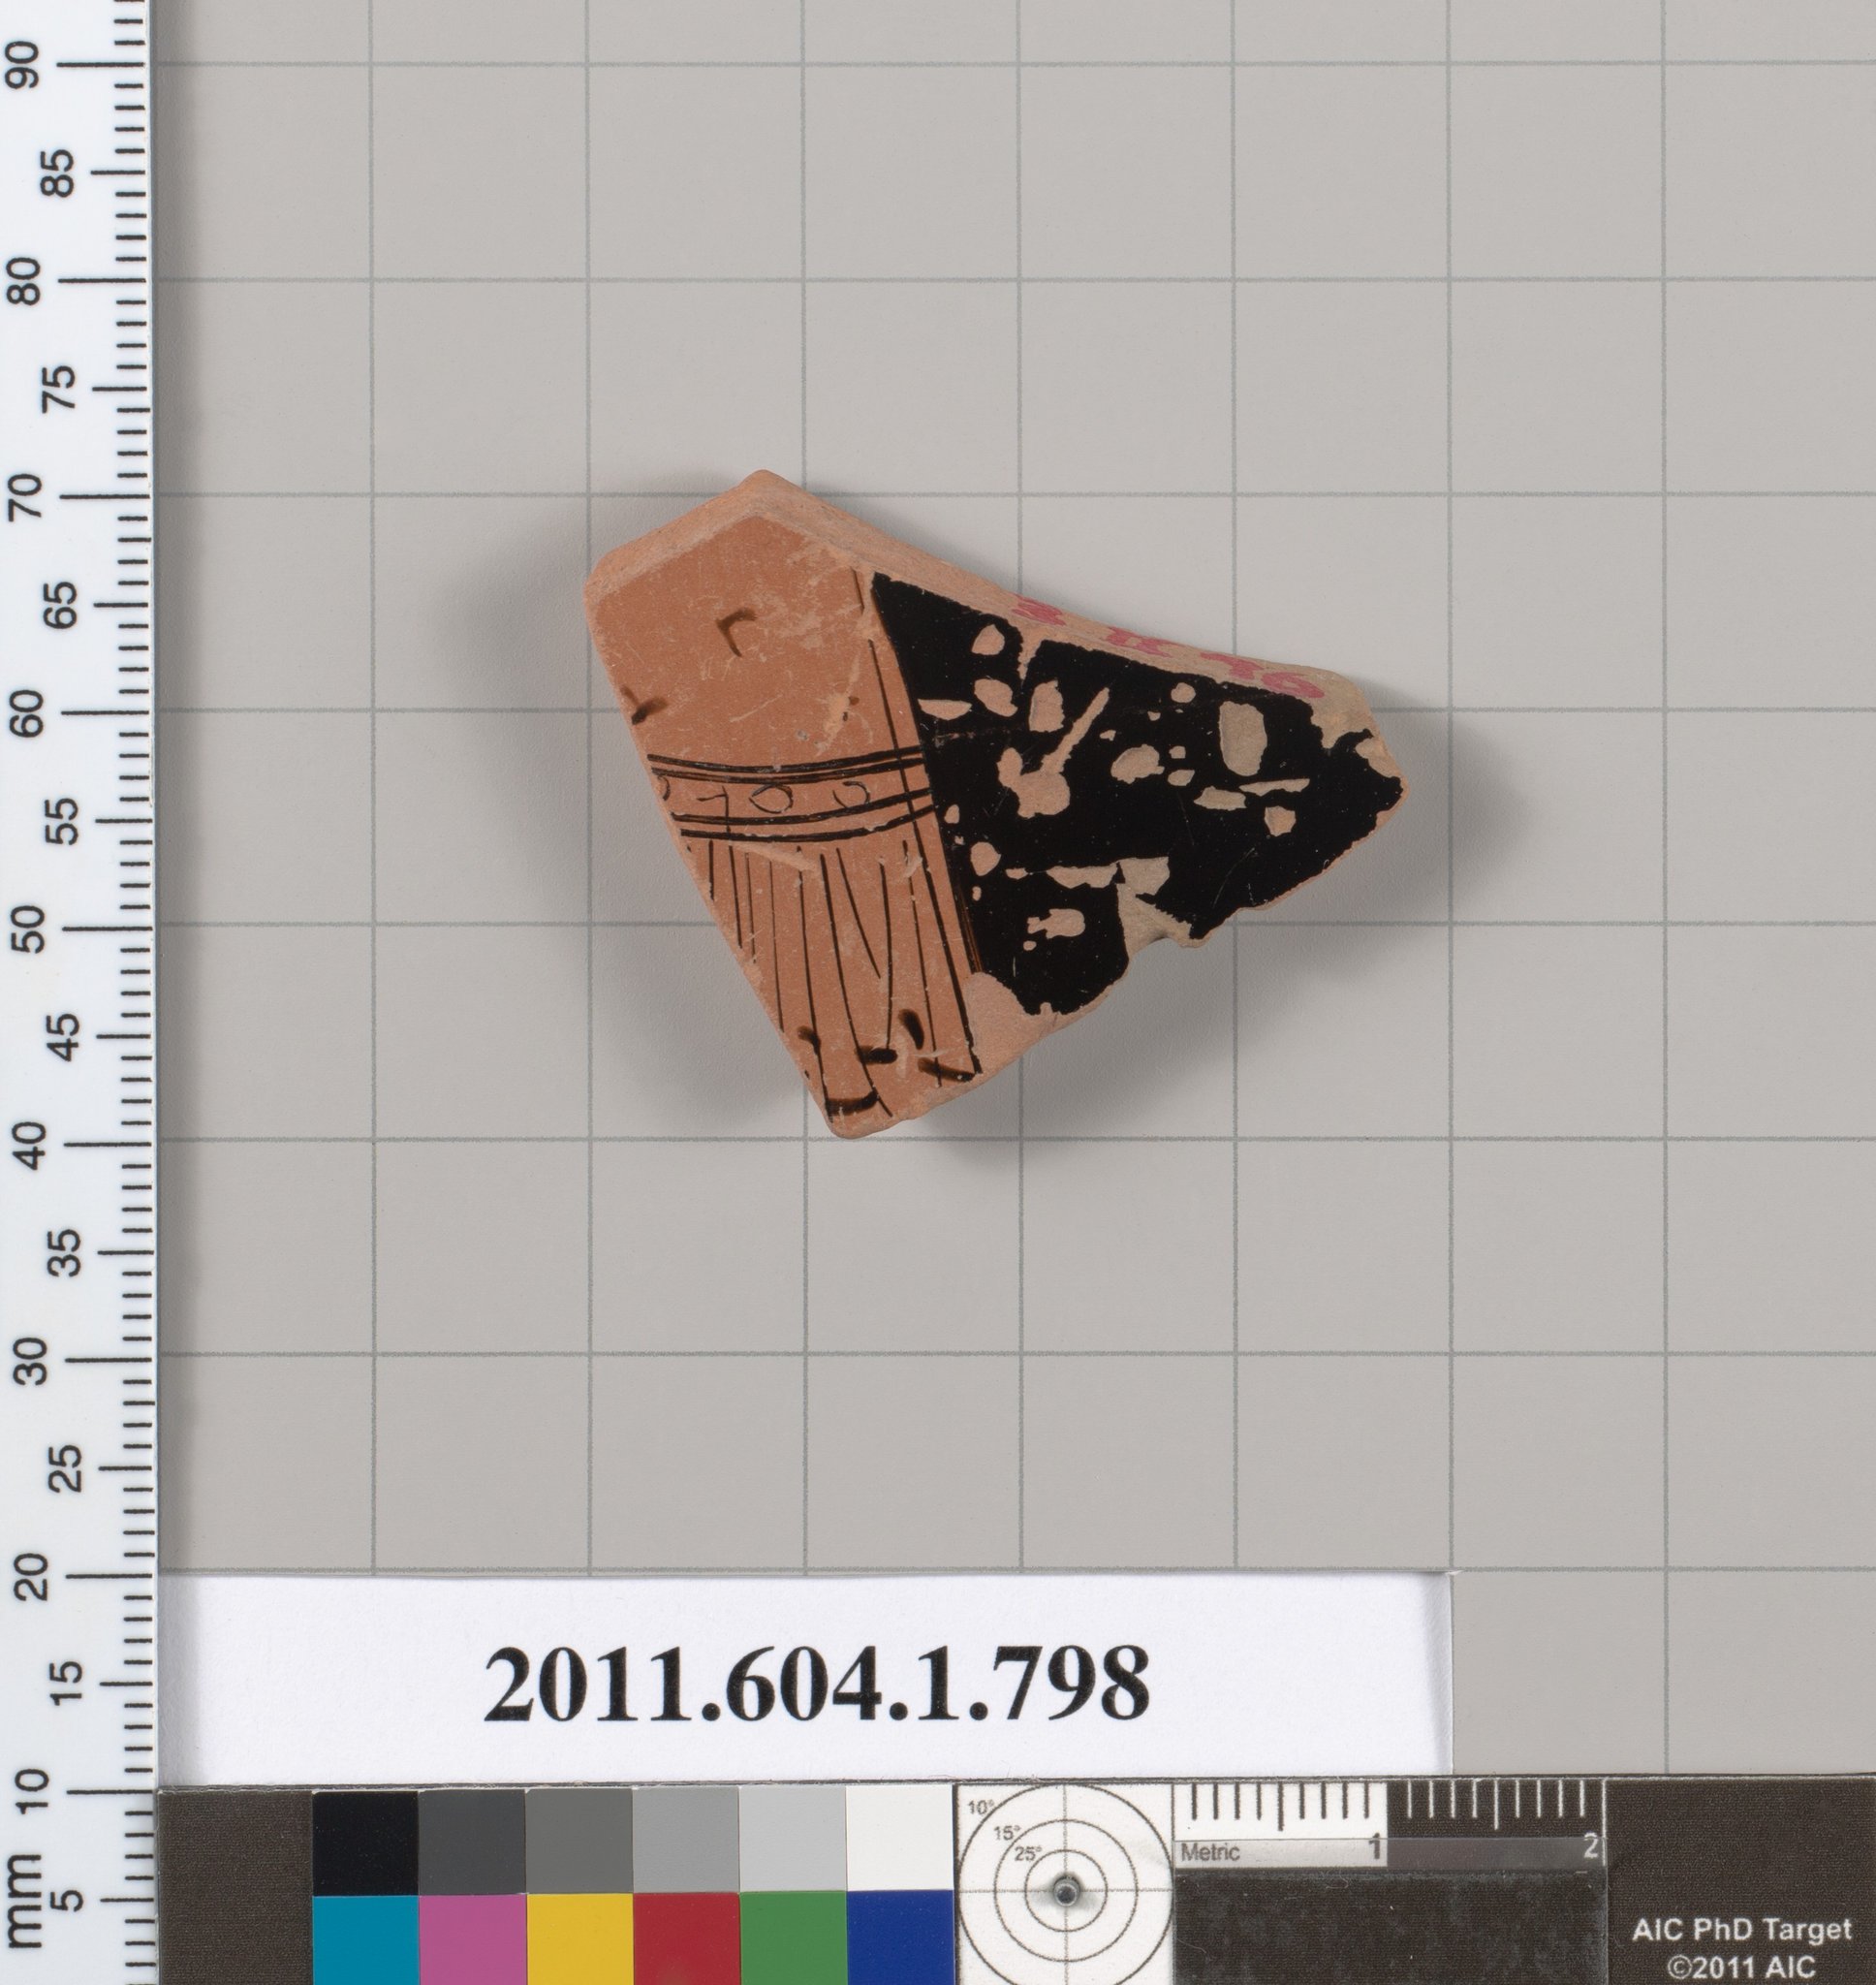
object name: kylix fragment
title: Terracotta fragment of a kylix (drinking cup)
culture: greek, attic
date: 475-451 BCE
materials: terracotta